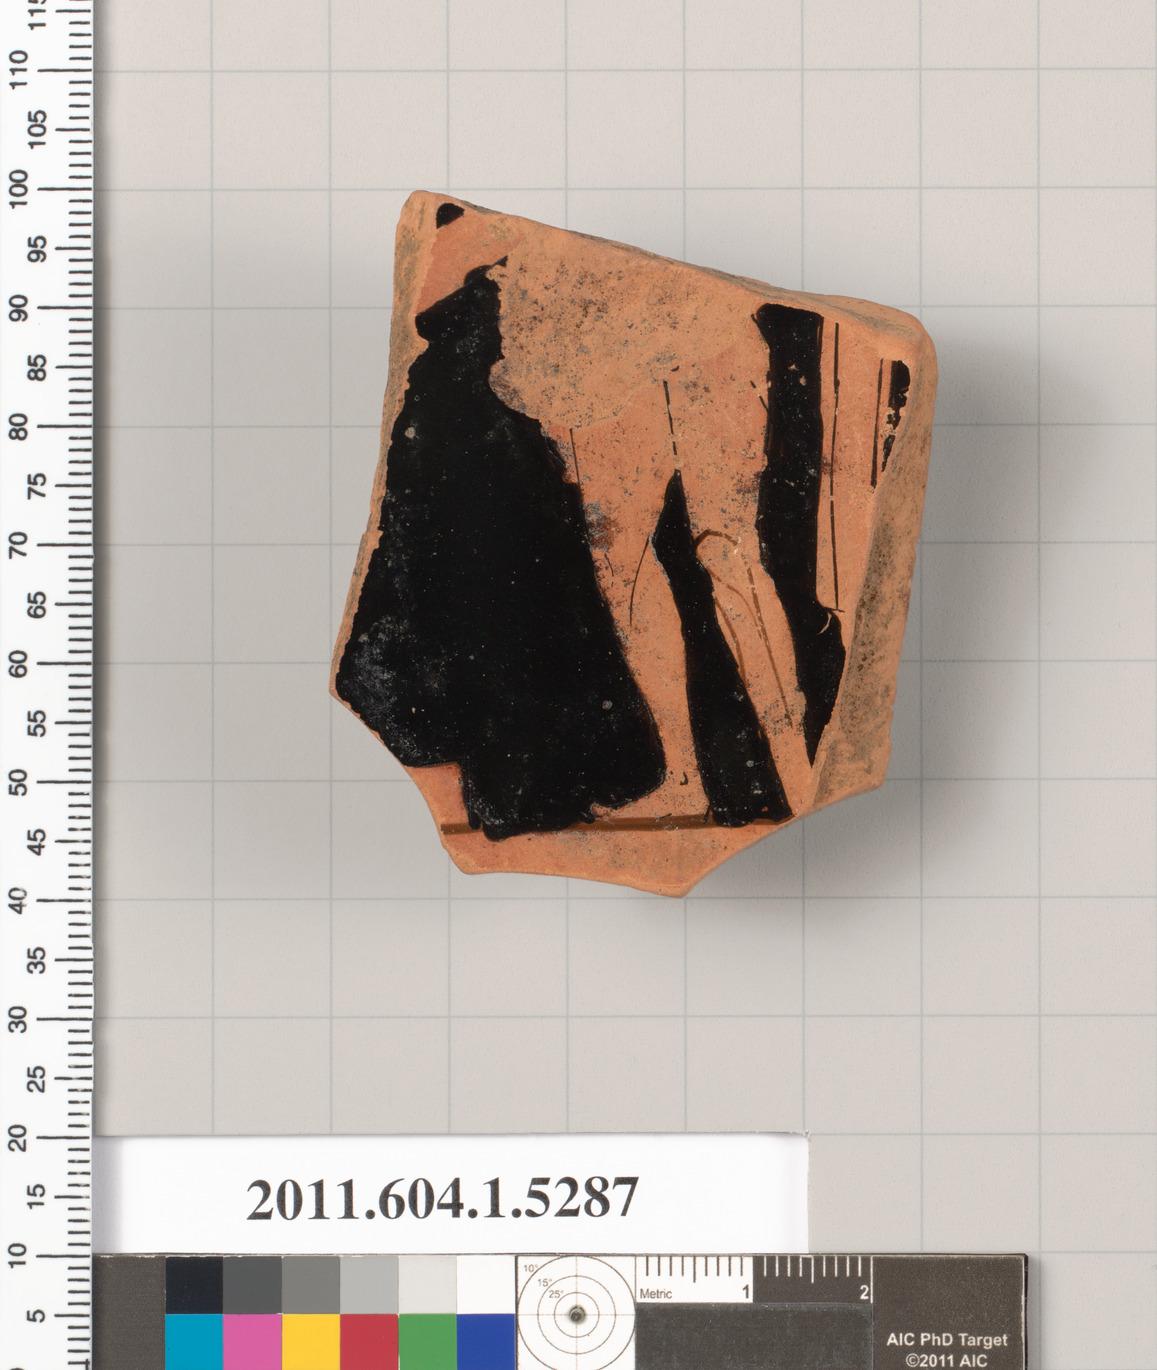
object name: kylix fragment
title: Terracotta fragment of a kylix (drinking cup)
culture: greek, attic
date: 475-451 BCE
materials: terracotta